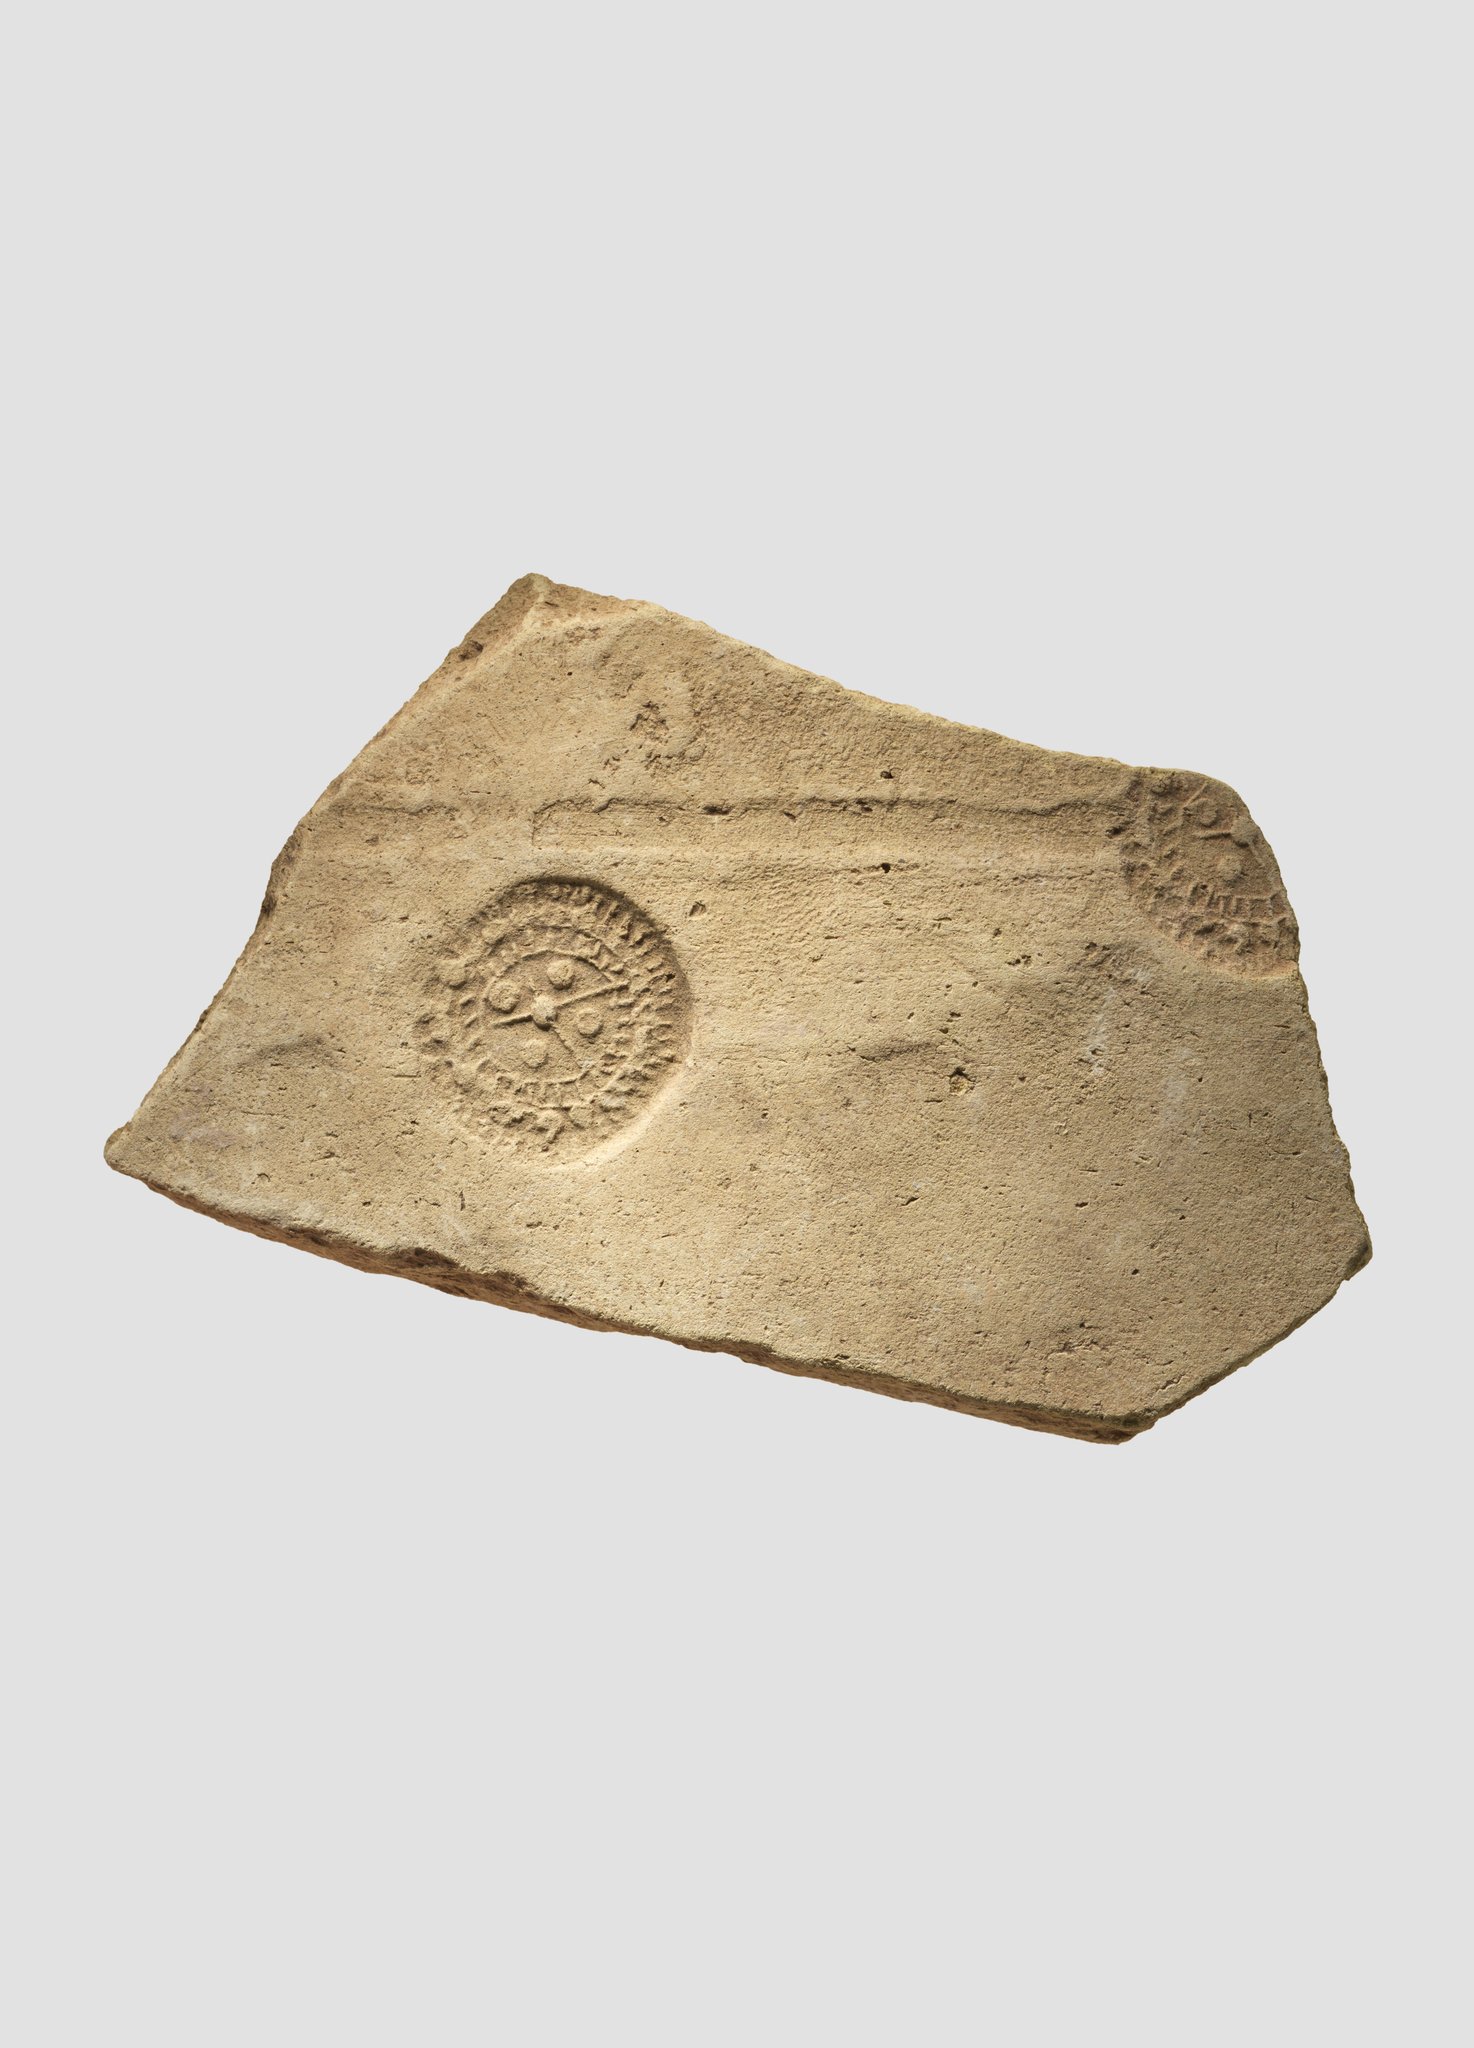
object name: sherd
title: Sherds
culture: sasanian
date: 201-700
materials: ceramic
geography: mesopotamia